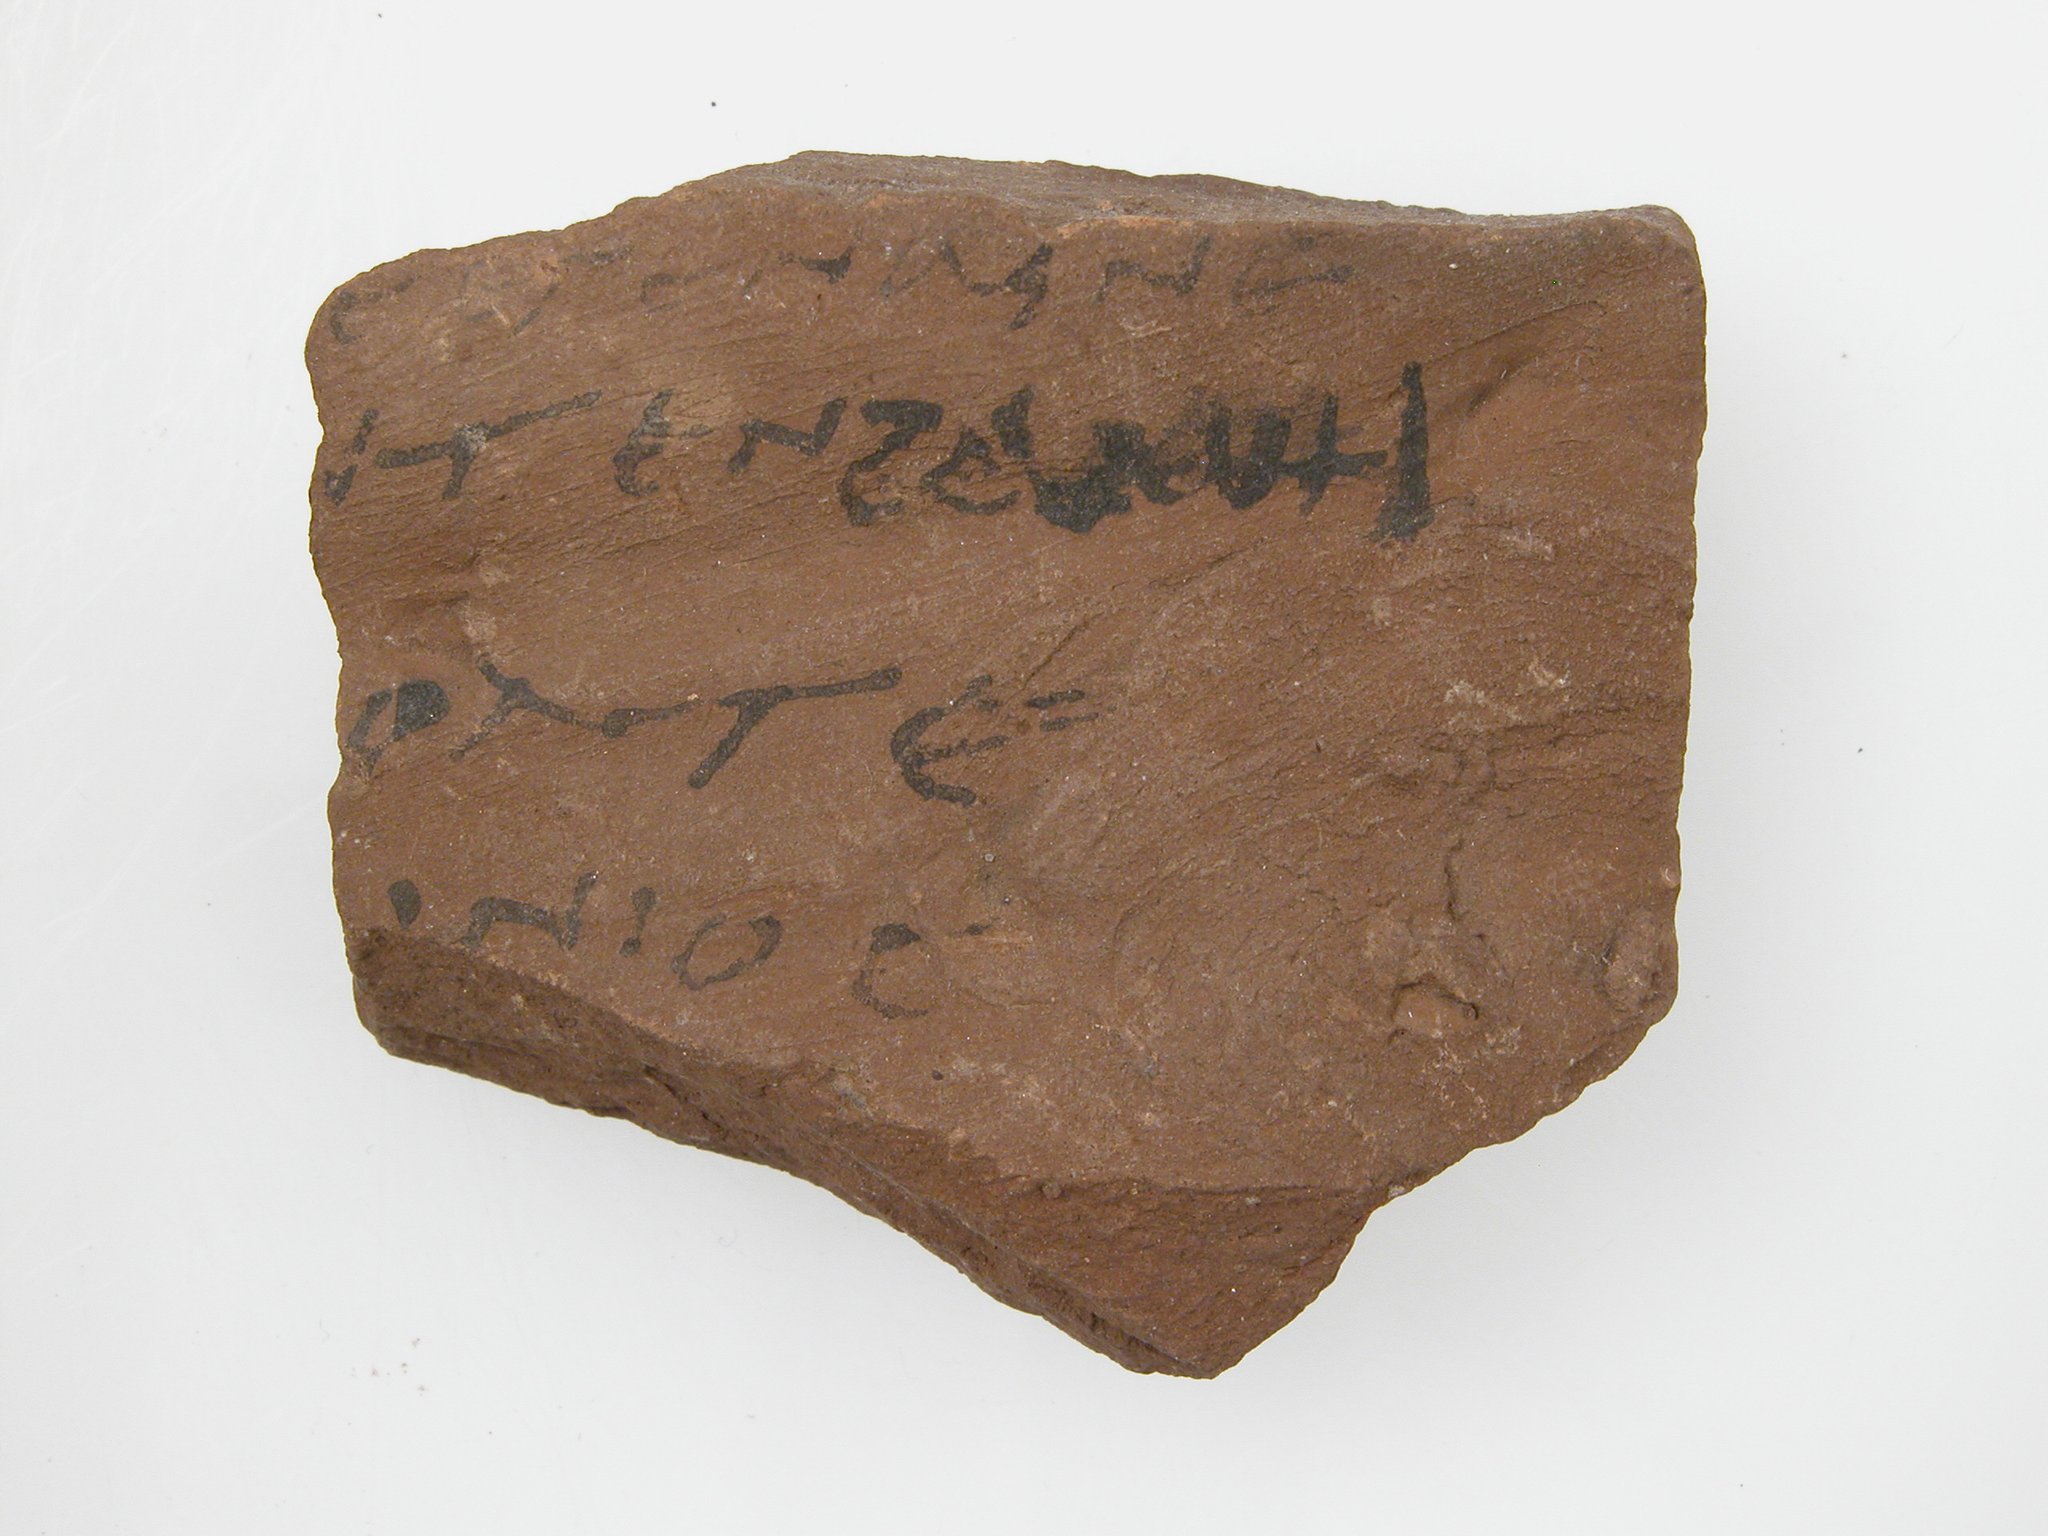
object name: ostrakon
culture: coptic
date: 601-700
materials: ink, pottery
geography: egypt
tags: documents